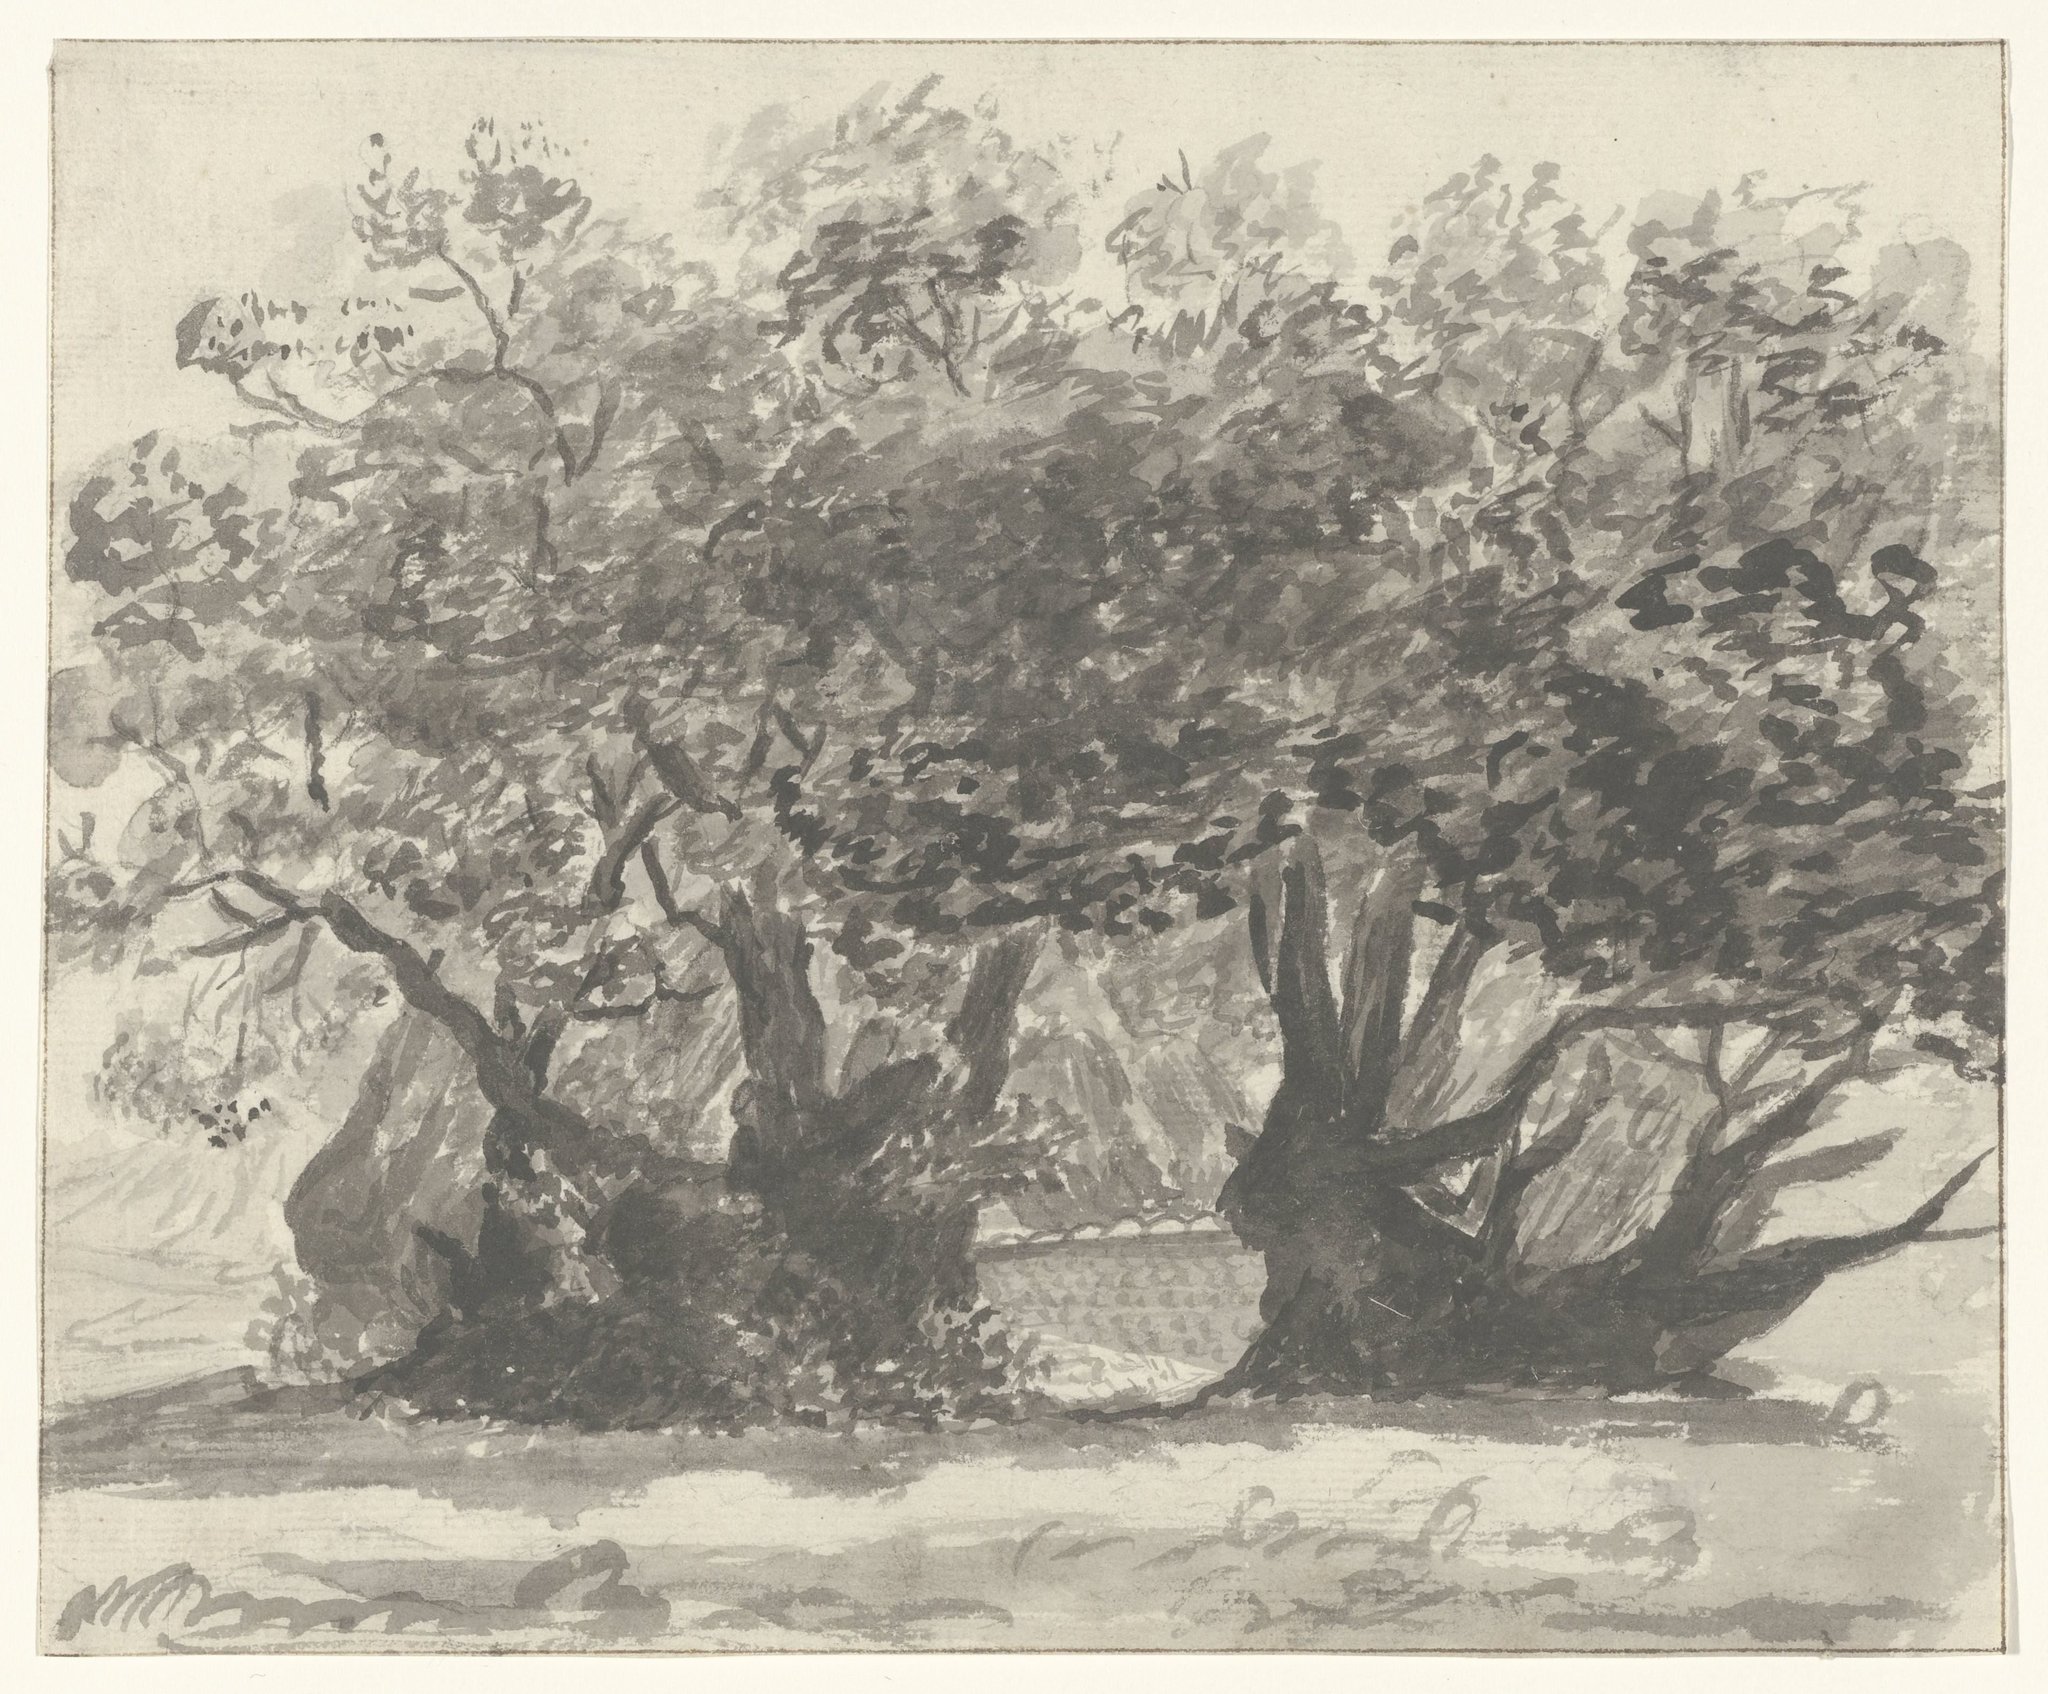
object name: drawing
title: Castagno di cento valli dans la regione Nemorosa de l'Etna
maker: willem carel dierkens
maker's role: draughtsman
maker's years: 1753-1778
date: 1778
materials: chalk, paper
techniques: brush, pen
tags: trees: chestnut-tree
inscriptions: inscription: ‘No 276 Castagno di cento valli dans la regione Nemorosa de l'Etna par Mr. Dierquens’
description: Tekening vervaardigd door Carel Willem Dierkens aldus opschrift verso.